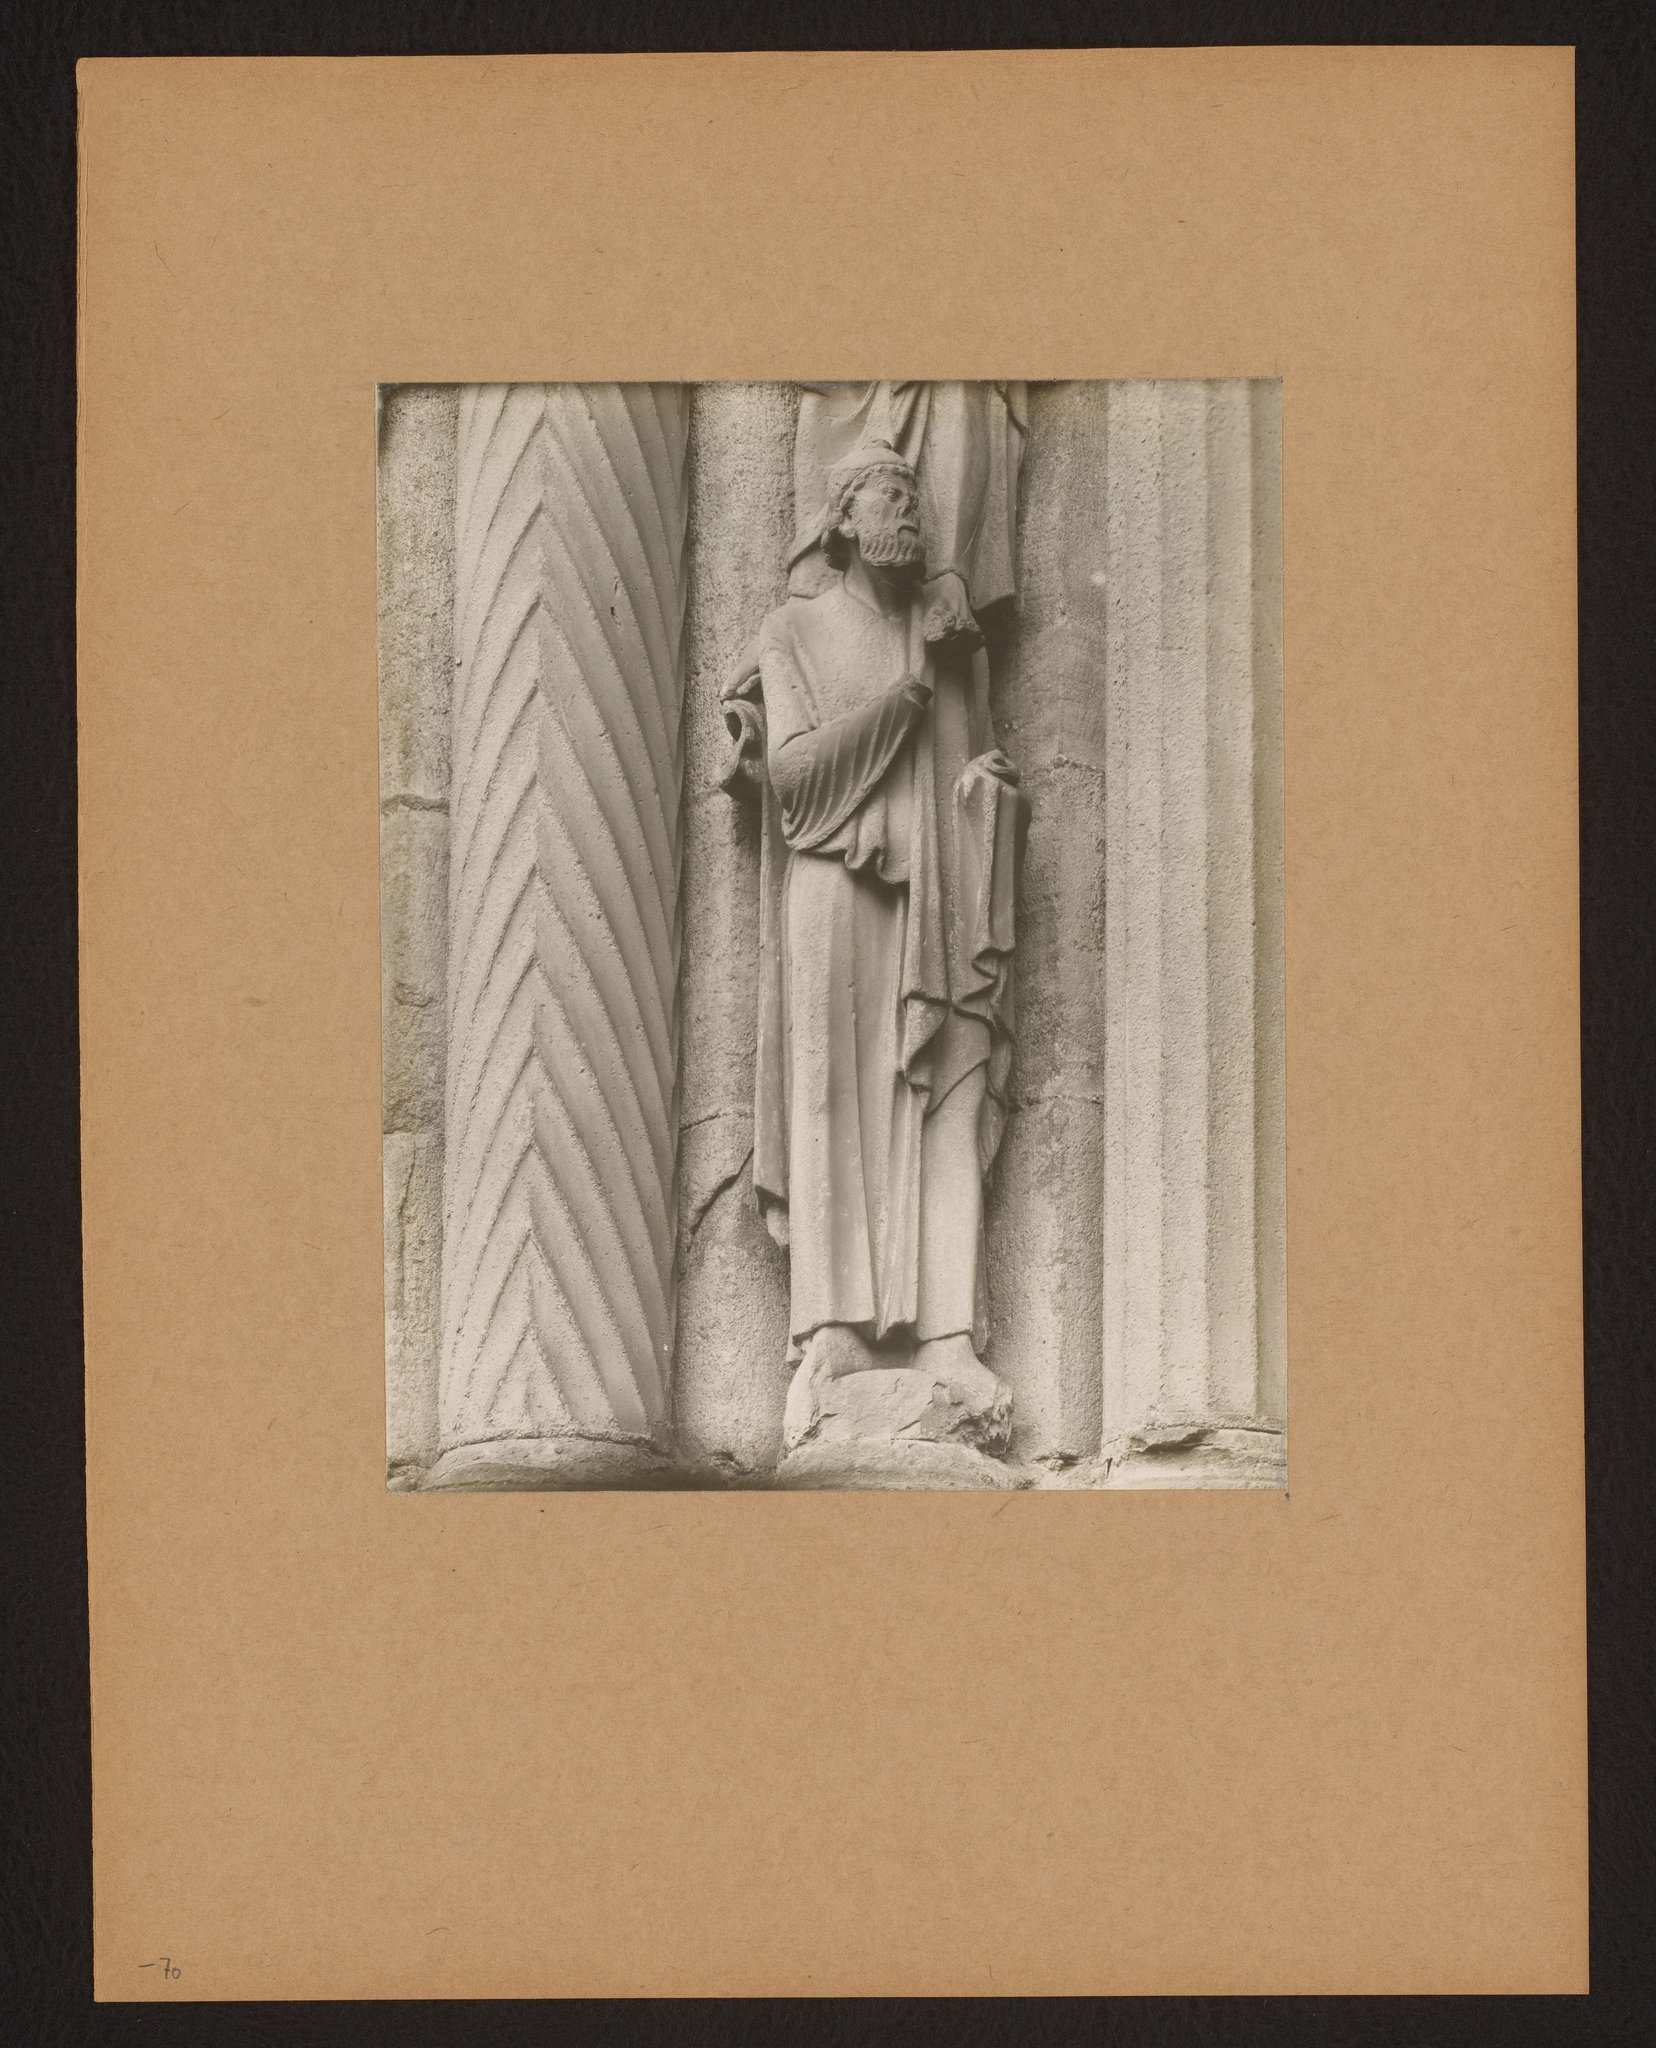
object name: photograph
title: Detail van de Fürstenportal in de dom van Bamberg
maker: Anonymous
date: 1900-1920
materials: paper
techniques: gelatin silver print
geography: bamberg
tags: church (exterior)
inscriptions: number: ‘72.’